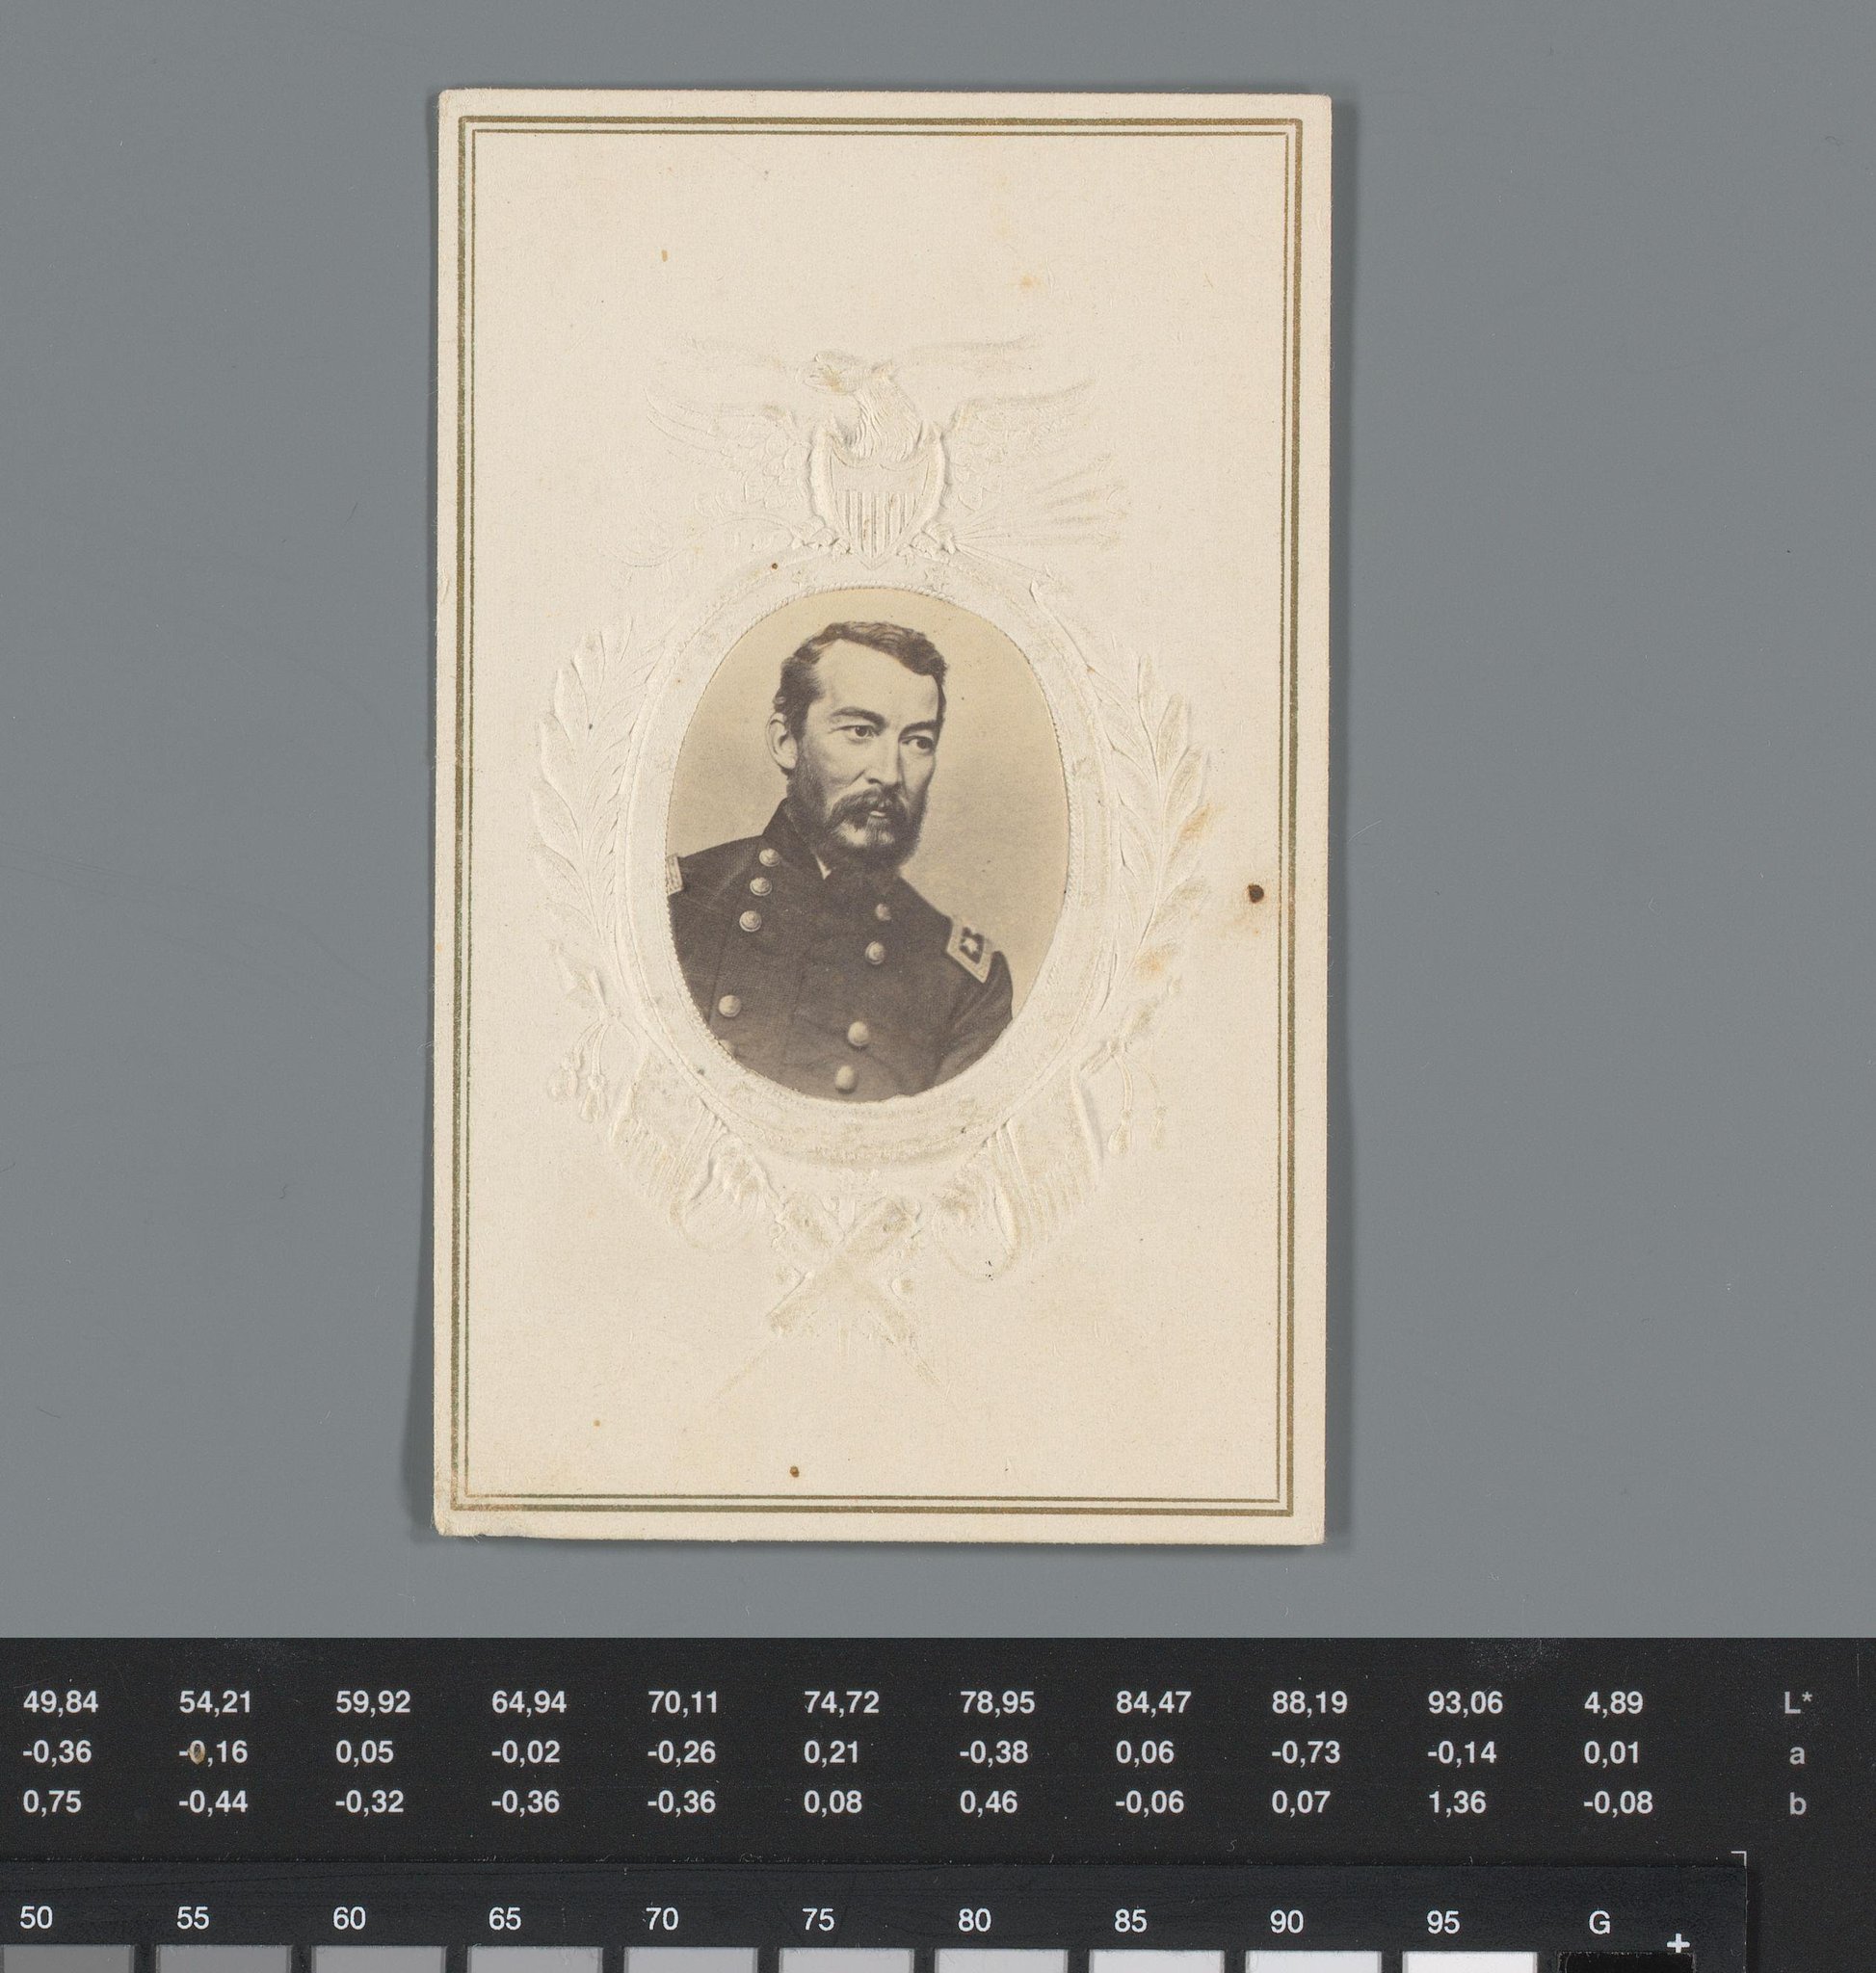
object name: photograph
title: Reclame voor gouden sierraden en cartes-de-visite van Salisbury Bro. & Co. met een portret van Philip Sheridan en patriottisch gepreegd kader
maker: Anonymous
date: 1850-1915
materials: cardboard, photographic support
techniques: albumen print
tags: advertising, commander-in-chief, general, marshal, historical persons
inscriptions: inscription: ‘AGENTS CAN MAKE / SALISBURY BRO. & CO., (...) / GOLD AND GOLD PLATED JUWELRY (...)’